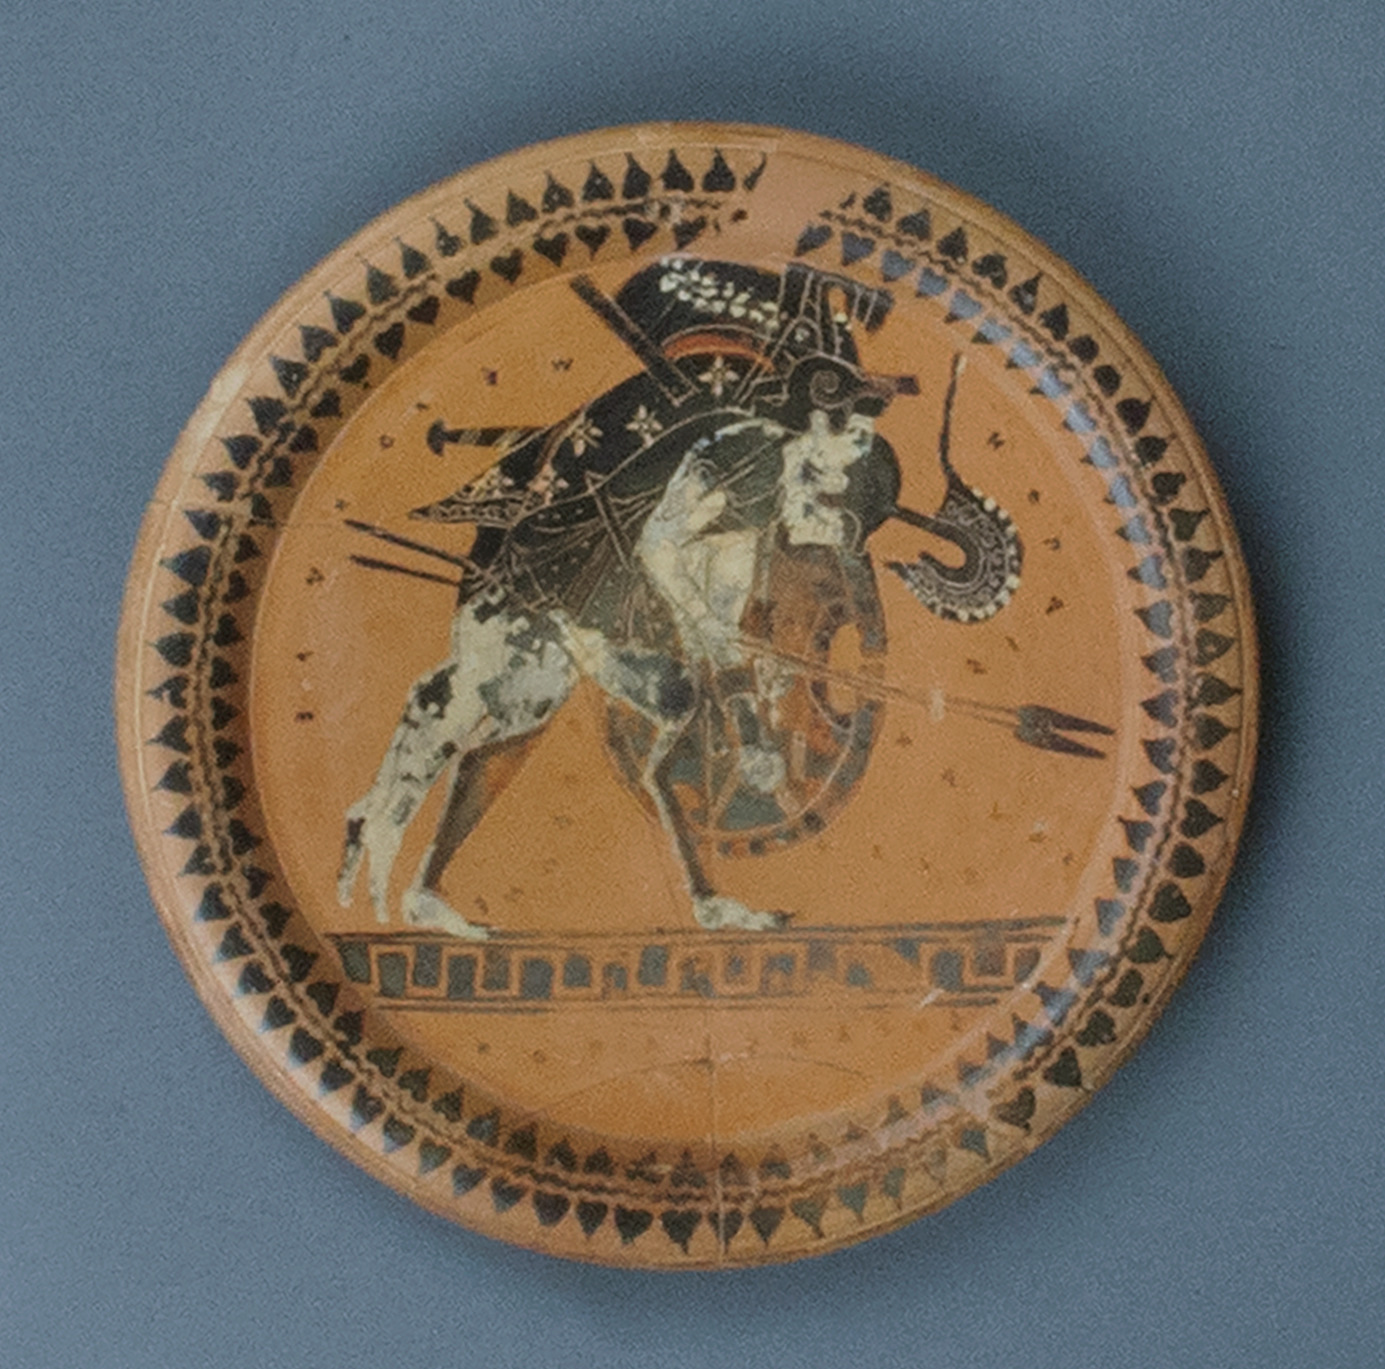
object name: plate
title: Terracotta plate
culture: greek, attic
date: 510 BCE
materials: terracotta